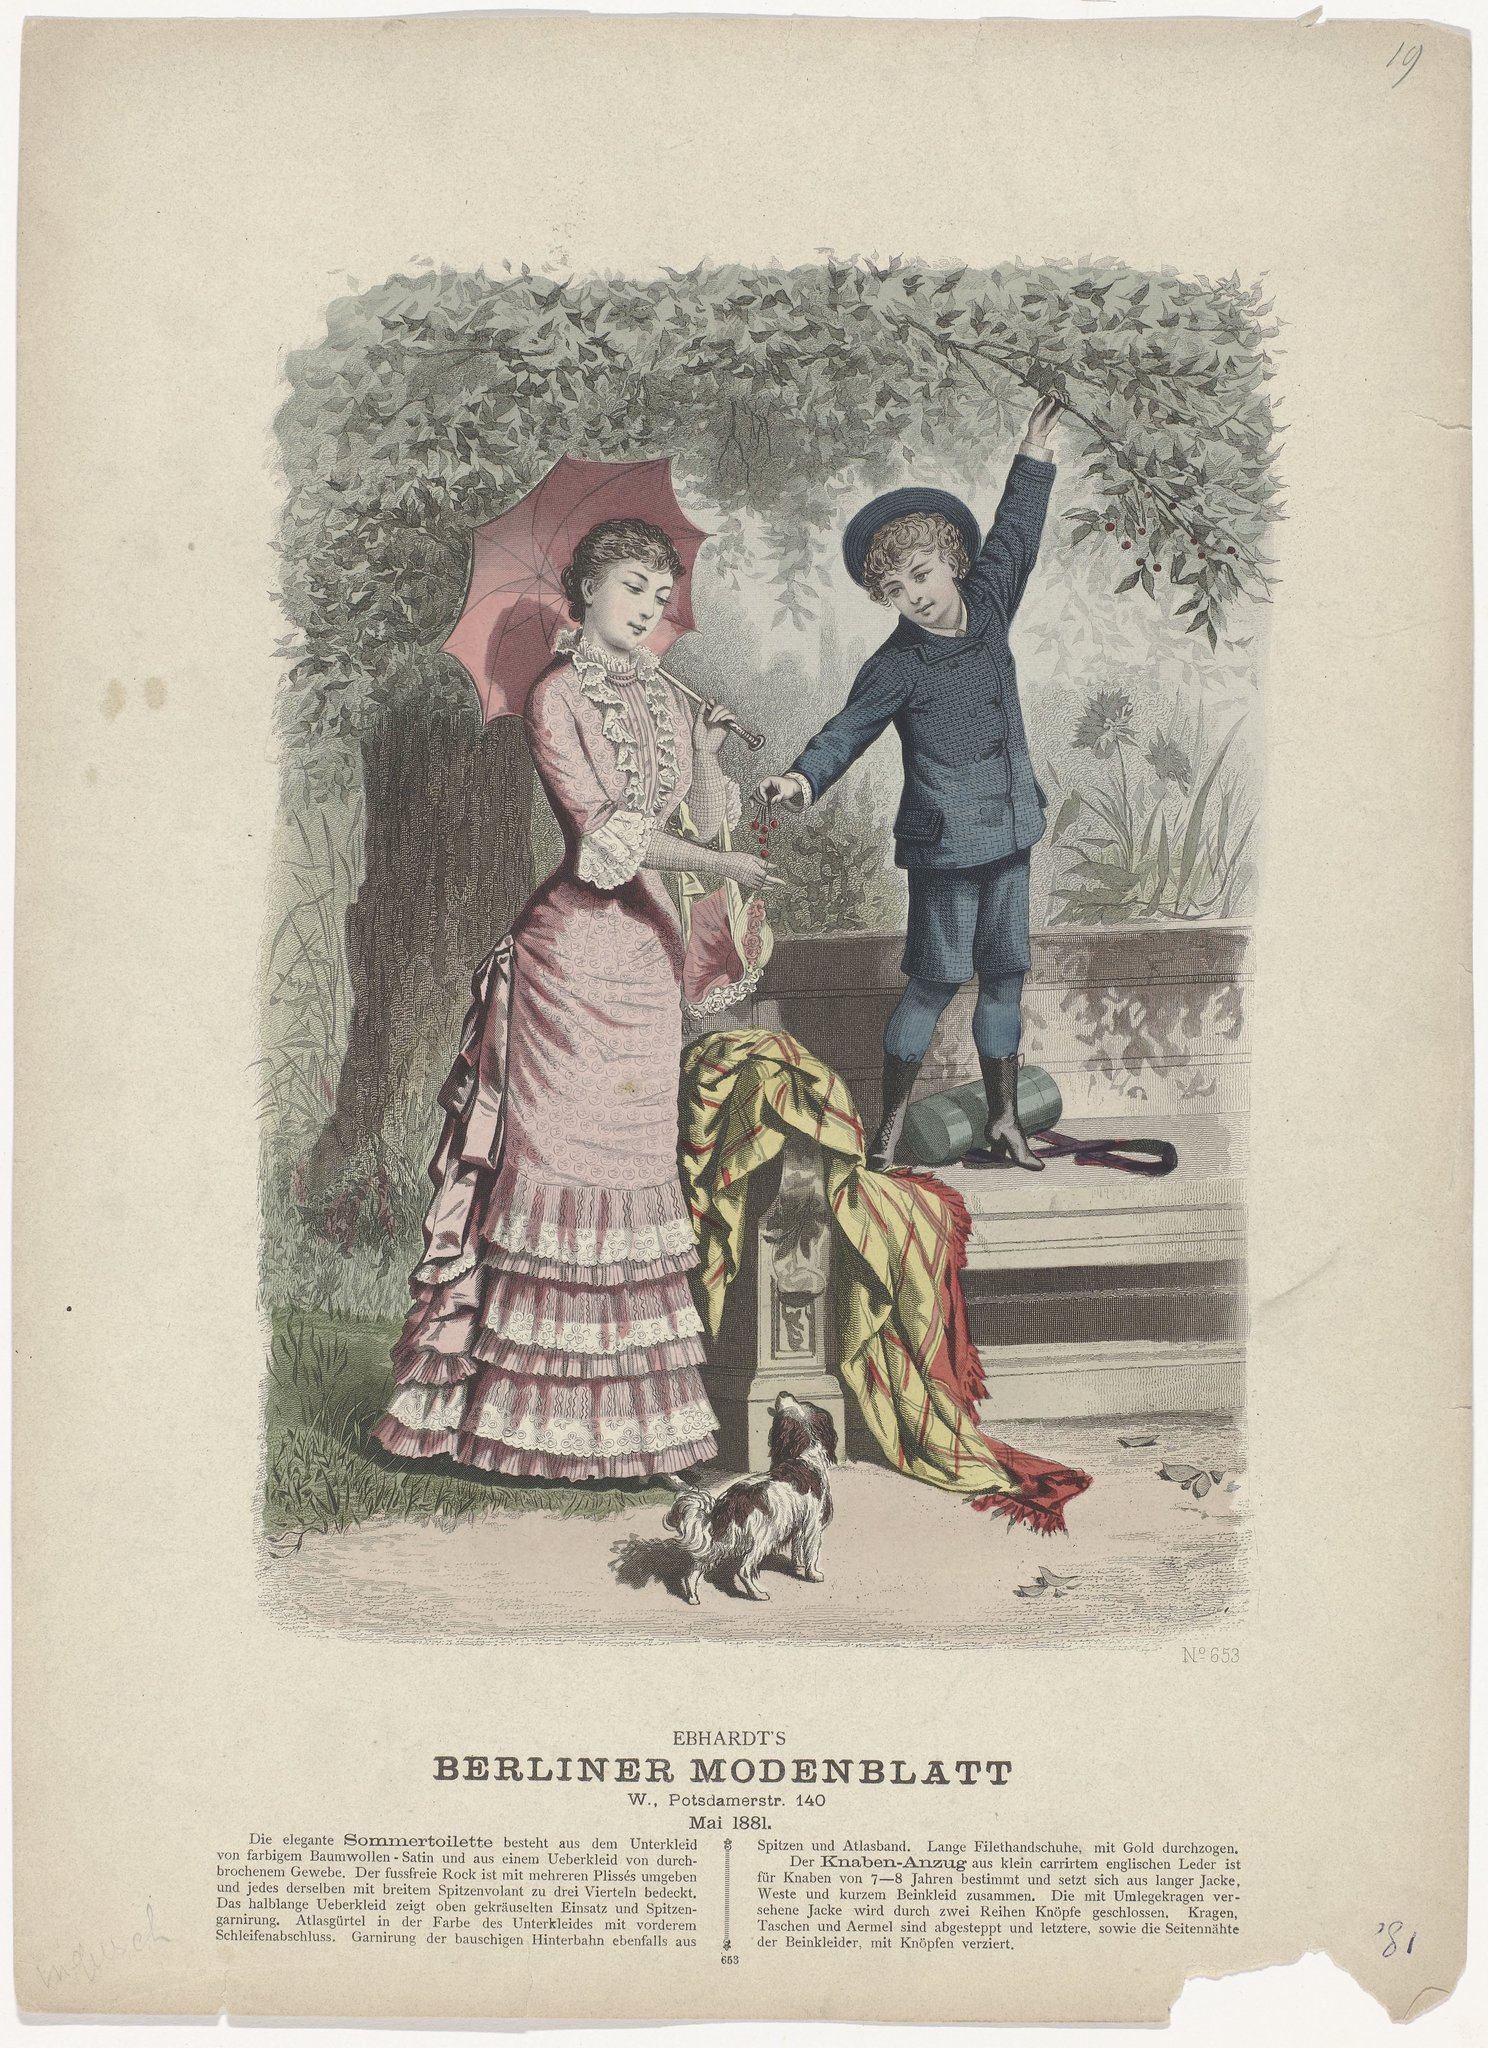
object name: fashion print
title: Berliner-Modenblatt, Mai 1881, Nr. 653 : Die elegante Sommertoilett (...)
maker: Anonymous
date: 1881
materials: paper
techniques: engraving, hand coloring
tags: clothing for the upper part of the body (shawl) (+ women's clothes), trousers, breeches, etc. (breeches) (+ boys' clothes), boots (+ boys' clothes), clothing for the upper part of the body (vest) (+ boys' clothes), gloves, mittens (mitaines) (+ women's clothes), dress, gown: day dress (+ women's clothes), head-gear: hat (+ boys' clothes), bag (+ boys' clothes), fashion plates, dress, gown (+ women's clothes), parasol, sunshade (+ women's clothes)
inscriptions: title: ‘EBHARDT'S / BERLINER MODENBLATT’, address: ‘W., Potsdamerstr. 140. / Mai 1881’, caption: ‘Die elegante Sommertoilette besteht aus dem unterkleid von farbigem Baumwollen - Satin und aus einem Ueberkleid von durch-brochenem Gewebe. Der fussfreie Rock ist mit mehreren Plissés umgeben und jedes derselben mit breitem Spitzenvolant zu drei Vierteln bedeckt. Das halblange Ueberkleid zeigt oben gekräuselten Einsatz und Spitzen-garnirung. Atlasgürtel in der Farbe des Unterkleides mit vorderem Schleiifenabschluss. Garnirung des bauschigen Hinterbahn ebenfalls aus / Spitzen und Atlasband. Lange Filethandschuhe, mit Gold durchzogen. / Der Knaben-Anzug aus klein carrirtem englischen leder ist für Knaben von 7-8 Jahren bestimmt und setzt sich aus langer Jacke, Weste und kurzem Beinkleid zusammen. Die mit Umlegekragen versehene Jacke wird durch zwie Reihen Knöpfe geschlossen. Kragen, taschen und Aermel sind abgesteppt und letztere, sowie die Seitennähte der Beinkleider, mit Knöpfen verziert.’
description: Zomerjapon van wol en satijn. Prent uit het modetijdschrift Berliner-Modenblatt (1879-1881).